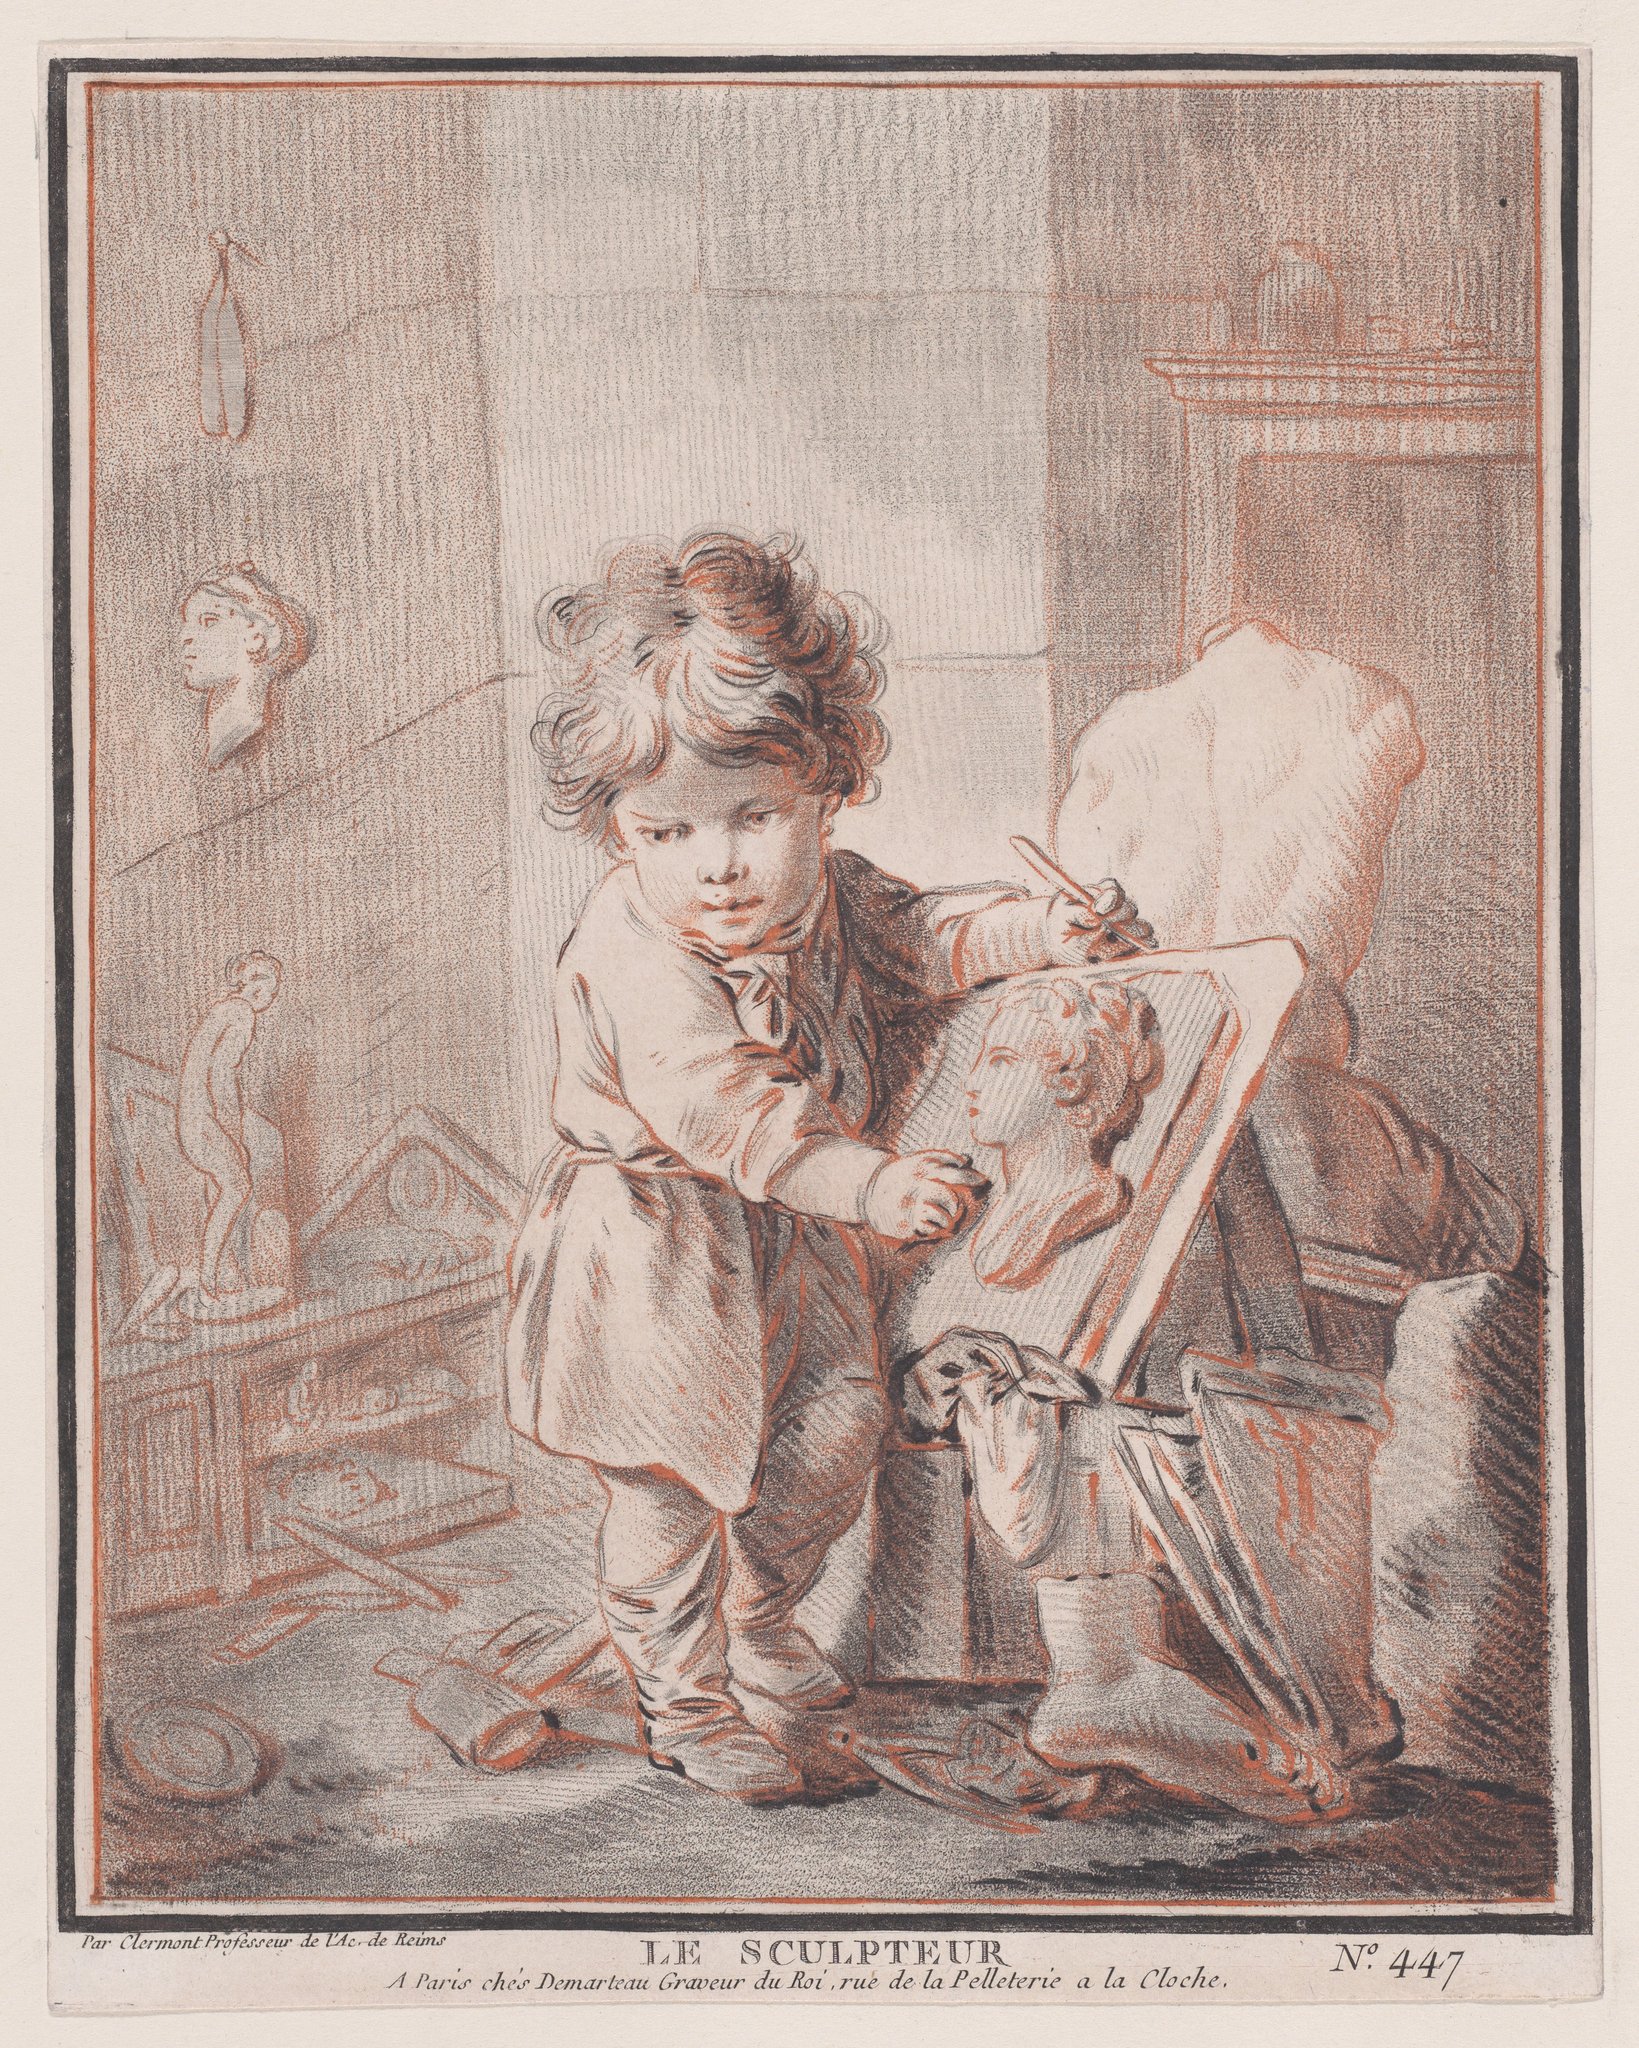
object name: print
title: Le Sculpteur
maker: gilles demarteau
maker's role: artist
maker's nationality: french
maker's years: 1722-1776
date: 1701-1800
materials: ink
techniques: printmaking, etching, printing